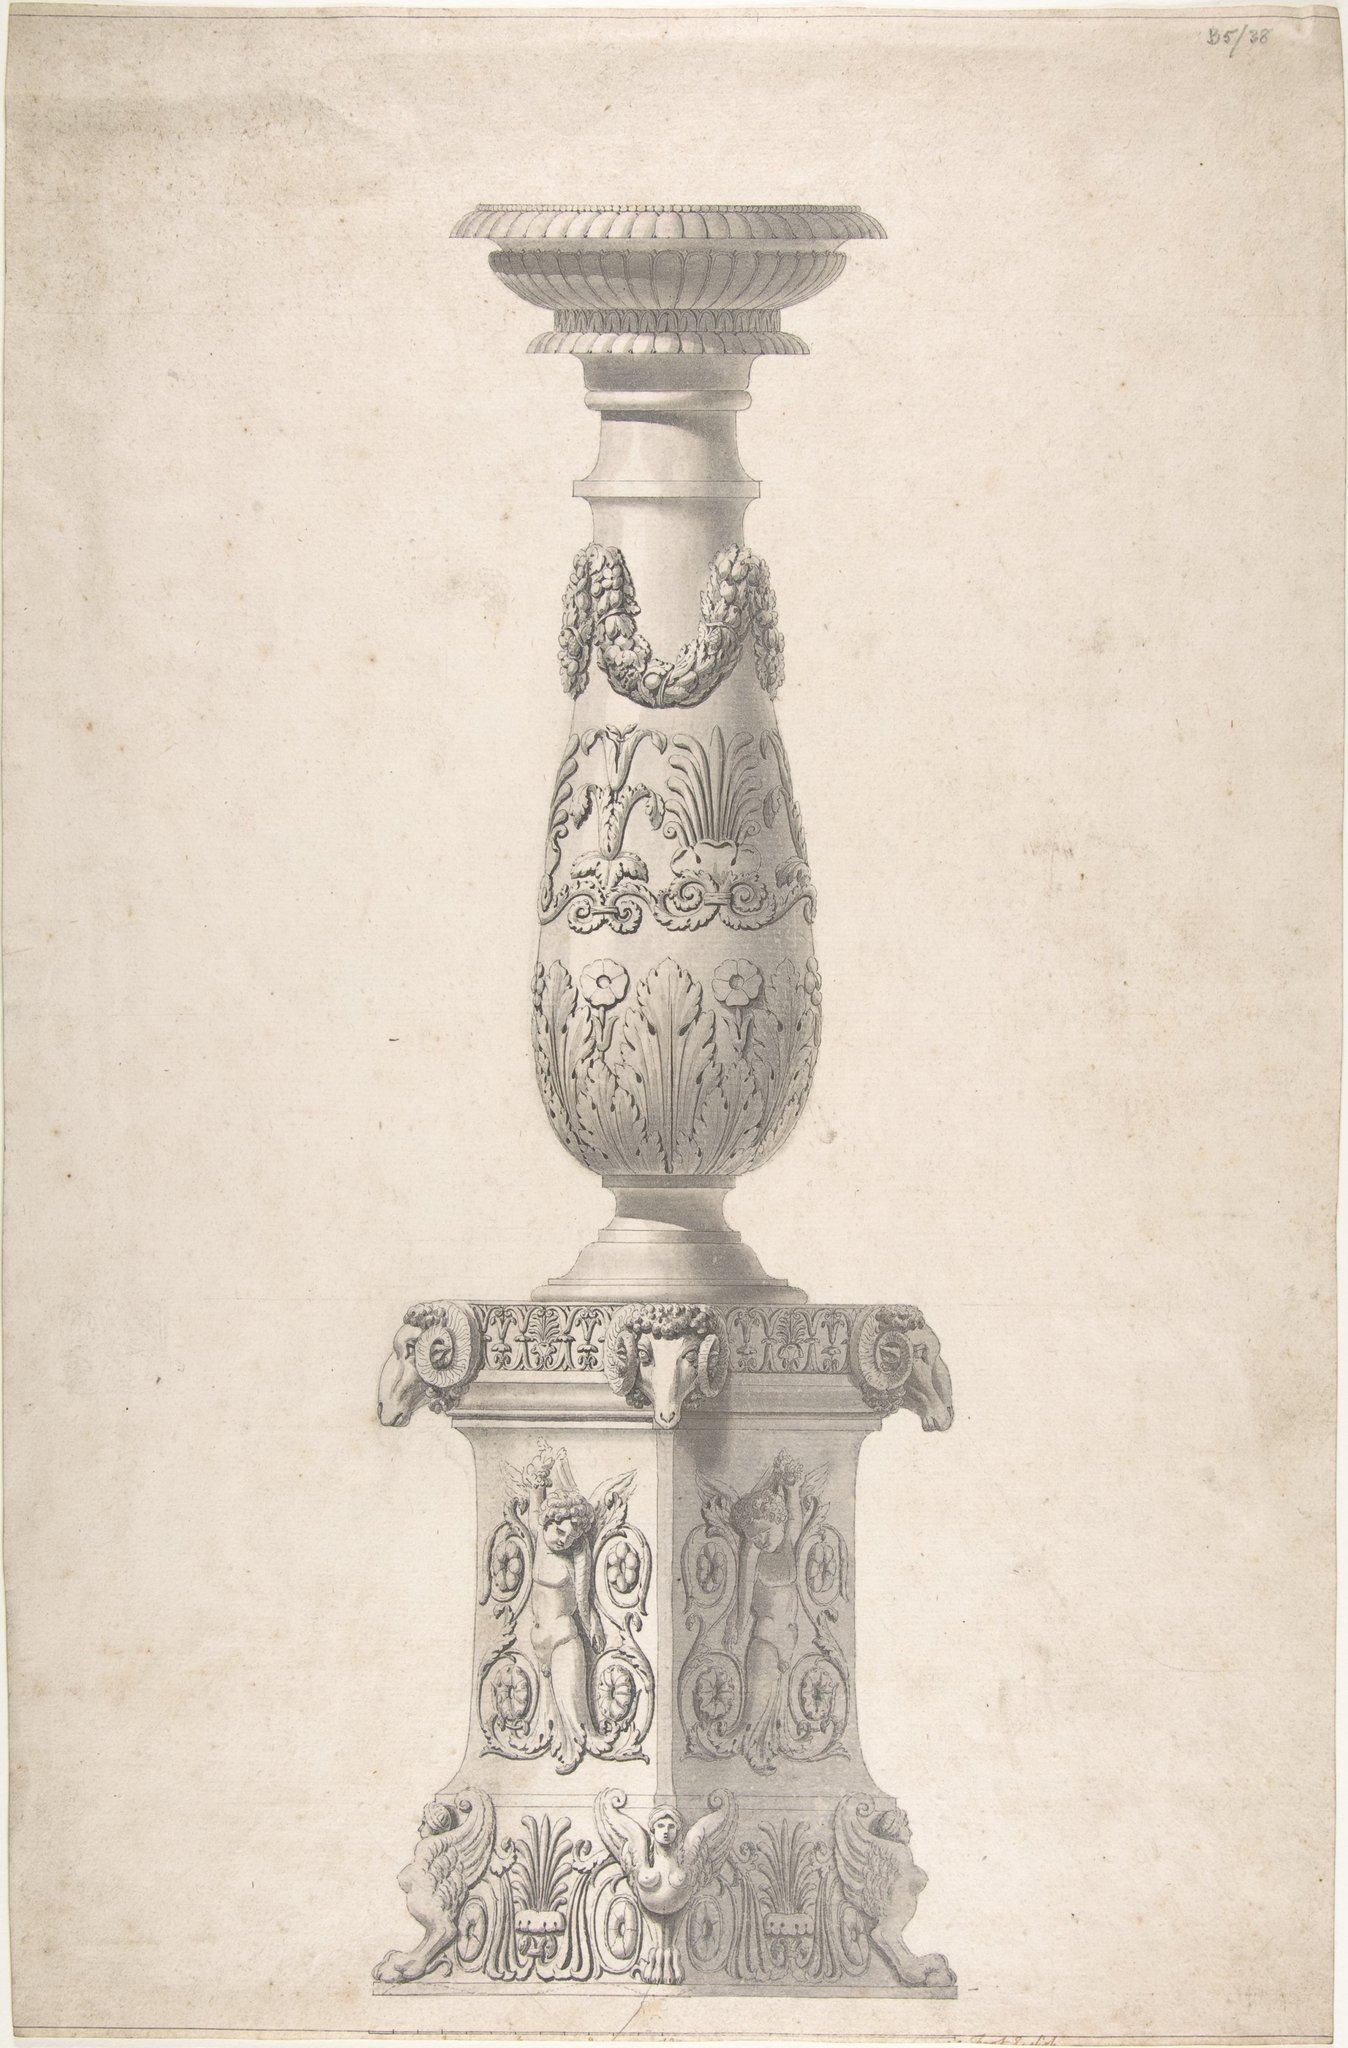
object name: drawing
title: Design for a candelabrum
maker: anonymous, british, 18th century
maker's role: artist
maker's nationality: british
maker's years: 1700-1800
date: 1701-1800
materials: ink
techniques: brush, pen, wash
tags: candelabra